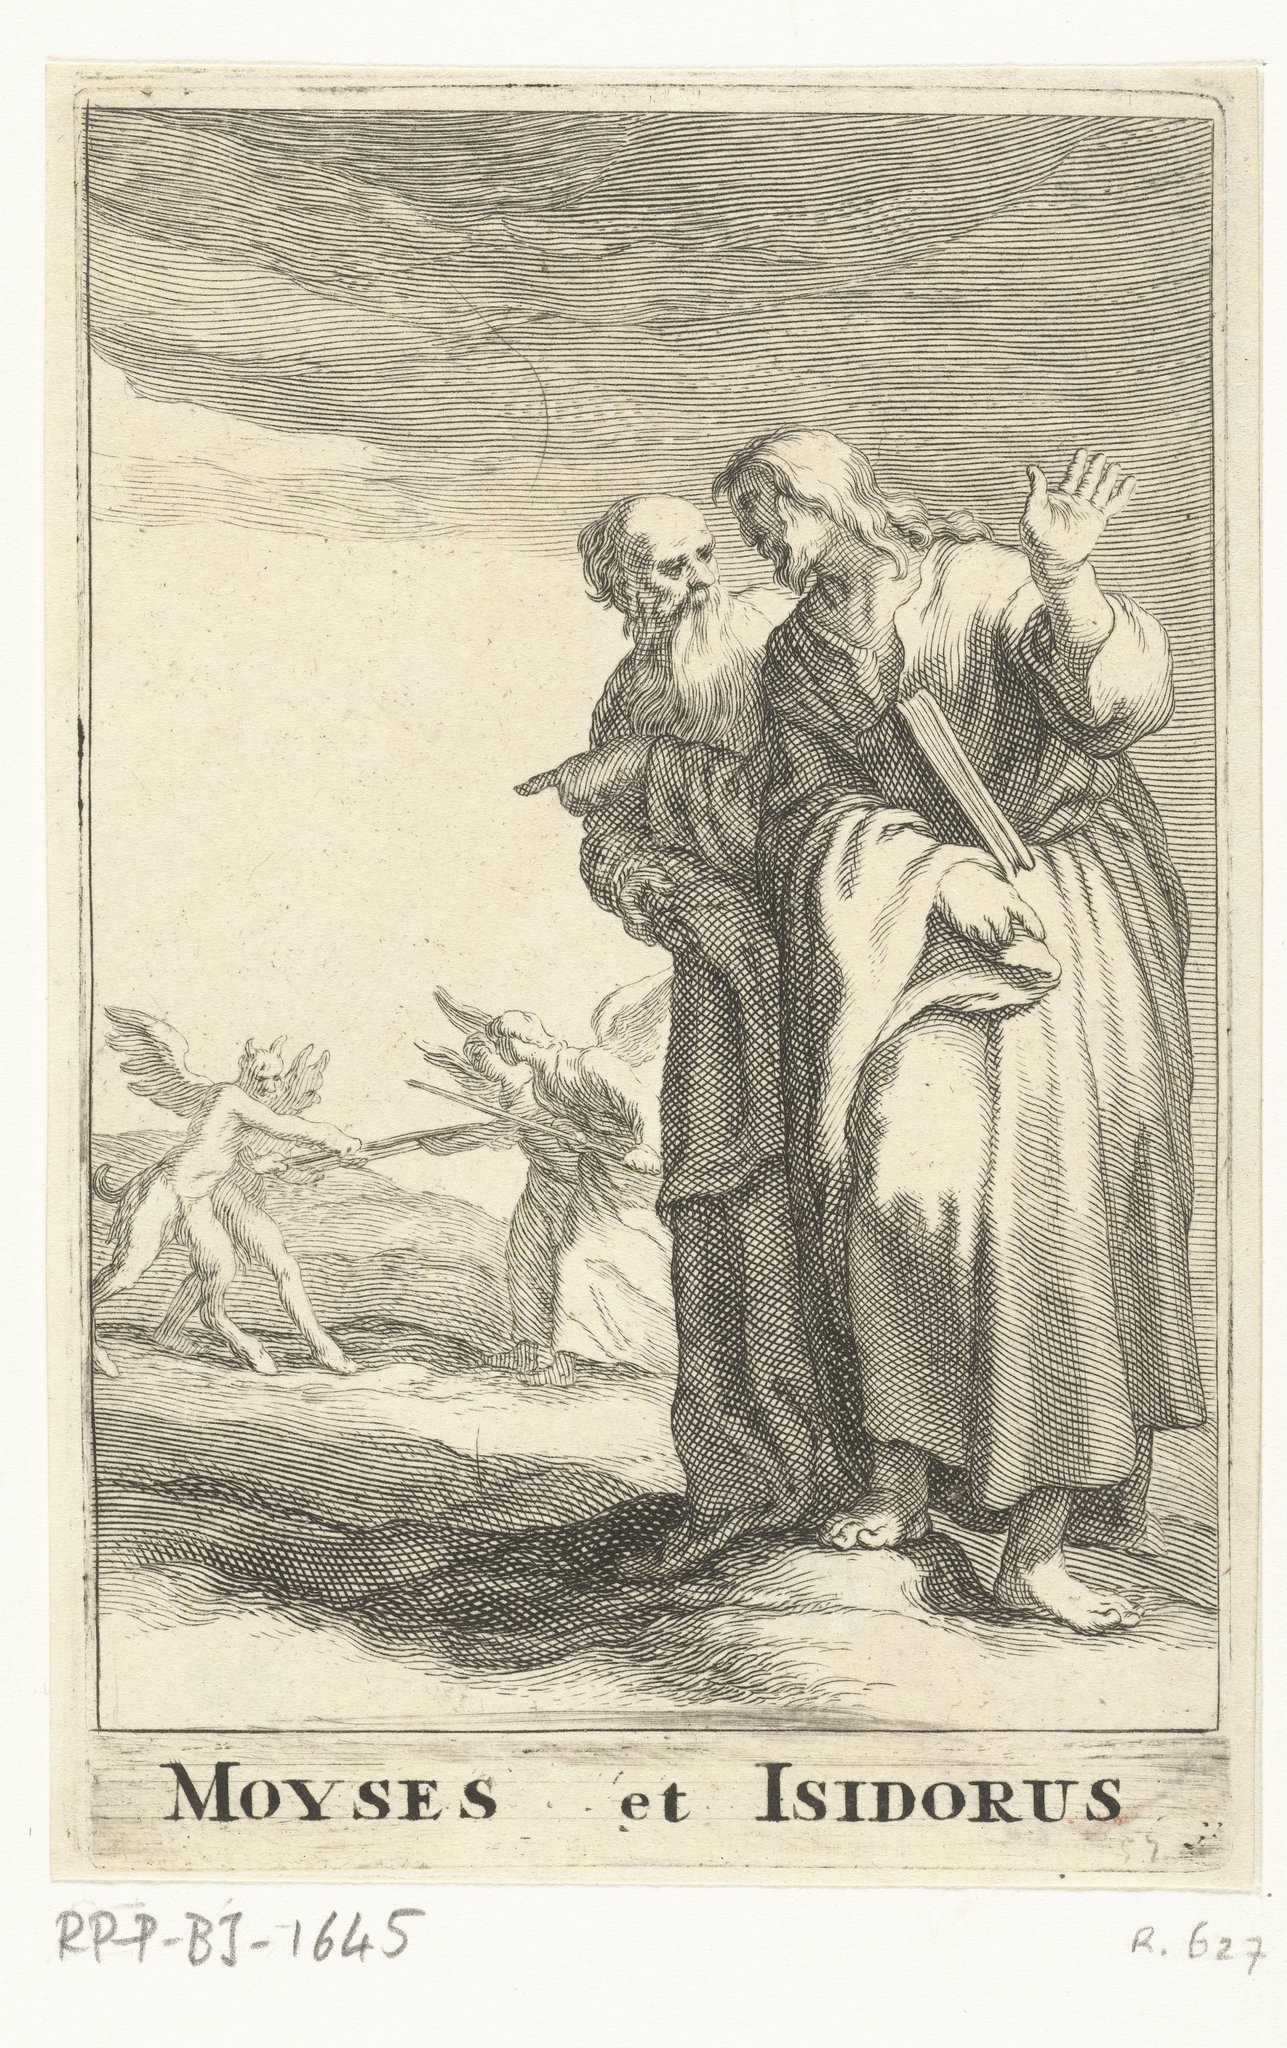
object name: print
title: Kluizenaars: Thebaanse heiligen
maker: frederick bloemaert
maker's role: print maker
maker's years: 1614-1669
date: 1636-1670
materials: paper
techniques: engraving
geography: utrecht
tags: male saints (with name), devil(s) and demons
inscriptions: number: ‘57’, collector's mark: Lugt 240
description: De heiligen Mozes de Zwarte en Isidorus zijn met elkaar in gesprek. Op de achtergrond twee engelen die tegen demonen vechten. Prent uit een serie van 80 prenten en een titelprent met kluizenaars uit de 2e tot de 6e eeuw.